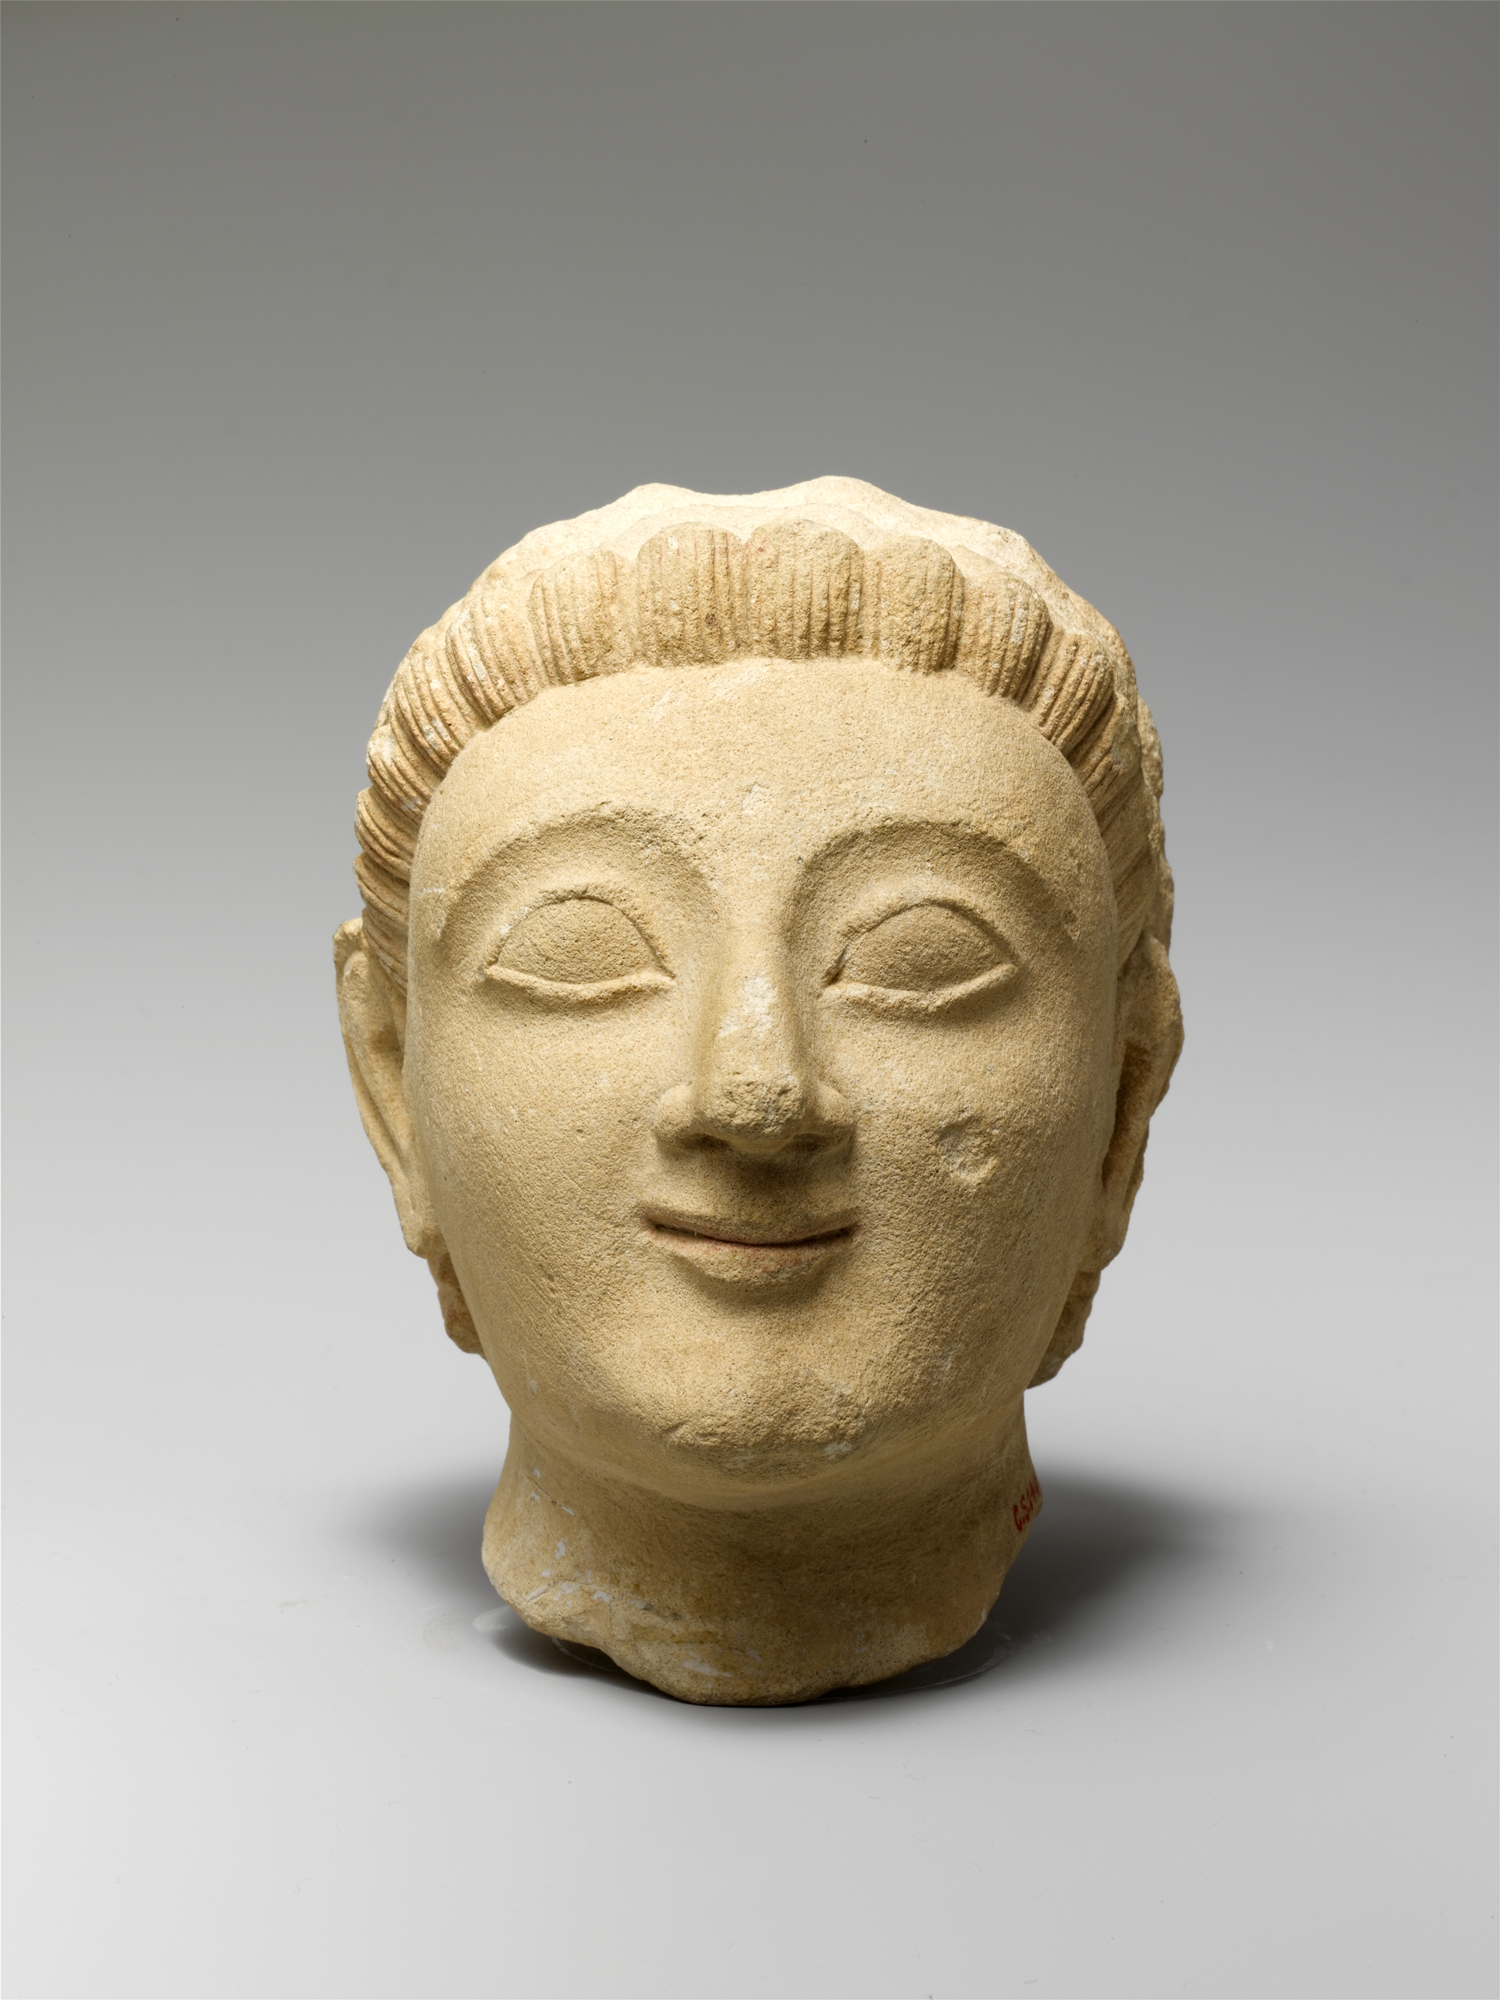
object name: head of a man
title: Limestone head of a beardless man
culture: cypriot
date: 530-520 BCE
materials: limestone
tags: heads,men